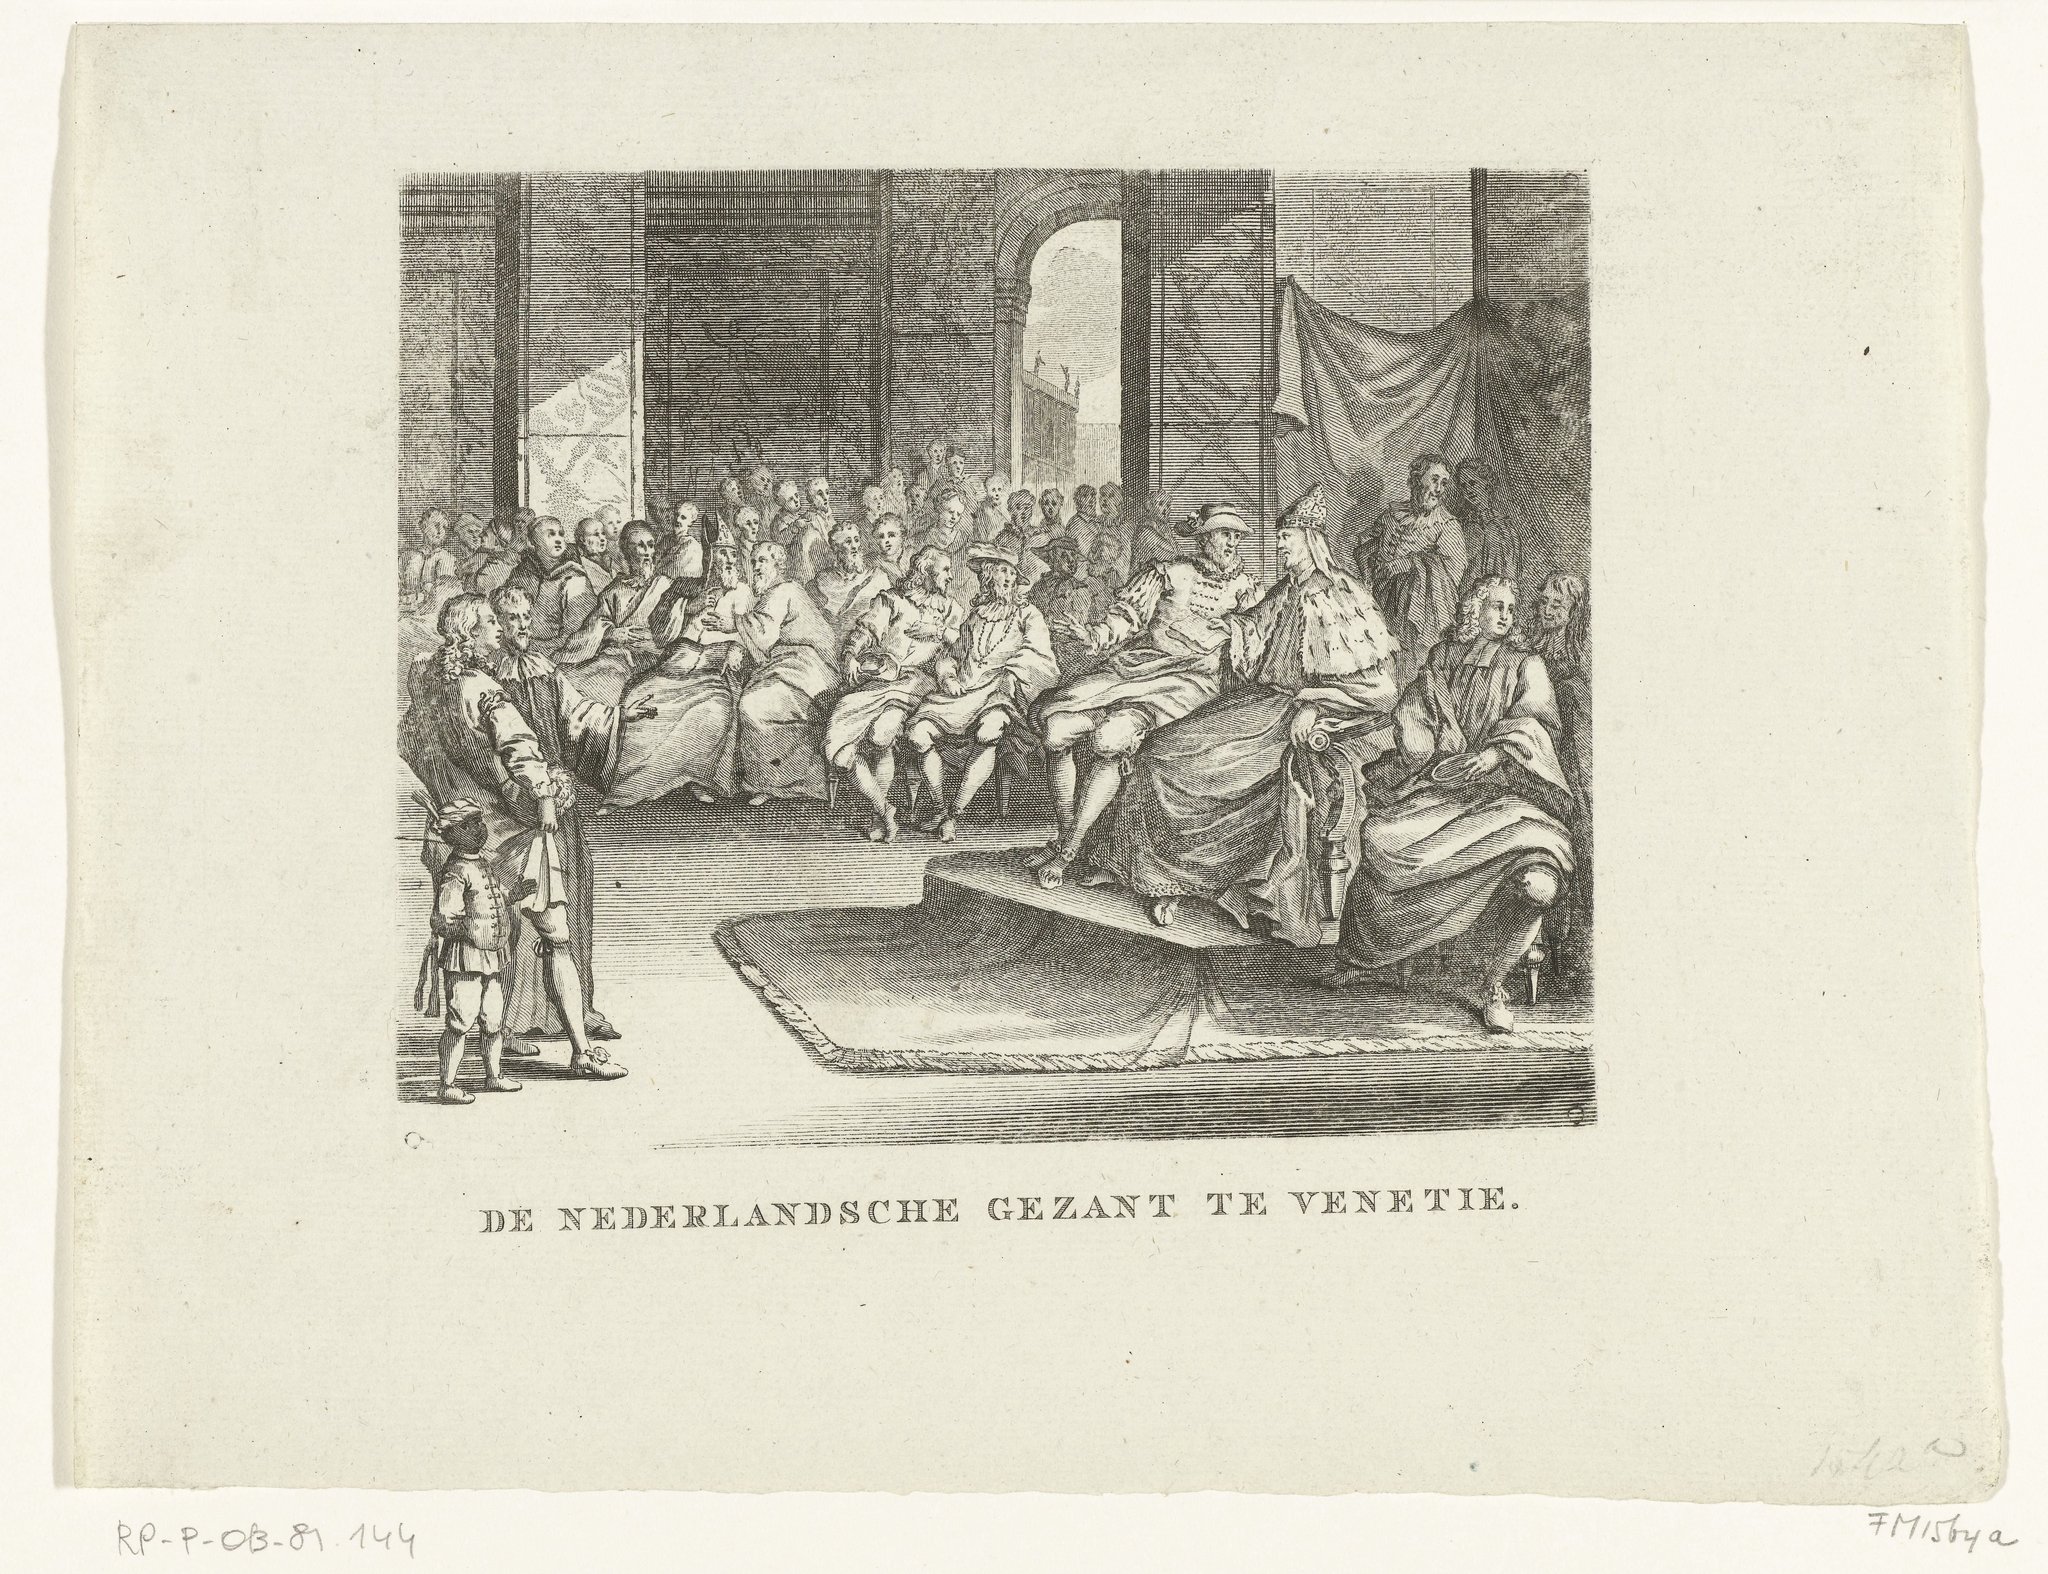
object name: print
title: De Nederlandse gezant Willem van Lier te Venetië, 1627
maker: matthijs pool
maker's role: print maker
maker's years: 1676-1740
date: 1700-1740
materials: paper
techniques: engraving, etching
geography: northern netherlands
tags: oosterwijk, audition; ruler giving audience, venice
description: De Nederlandse gezant Willem van Lier, heer van Oosterwijk op audiëntie bij de doge en het senaat van Venetië, 1627.